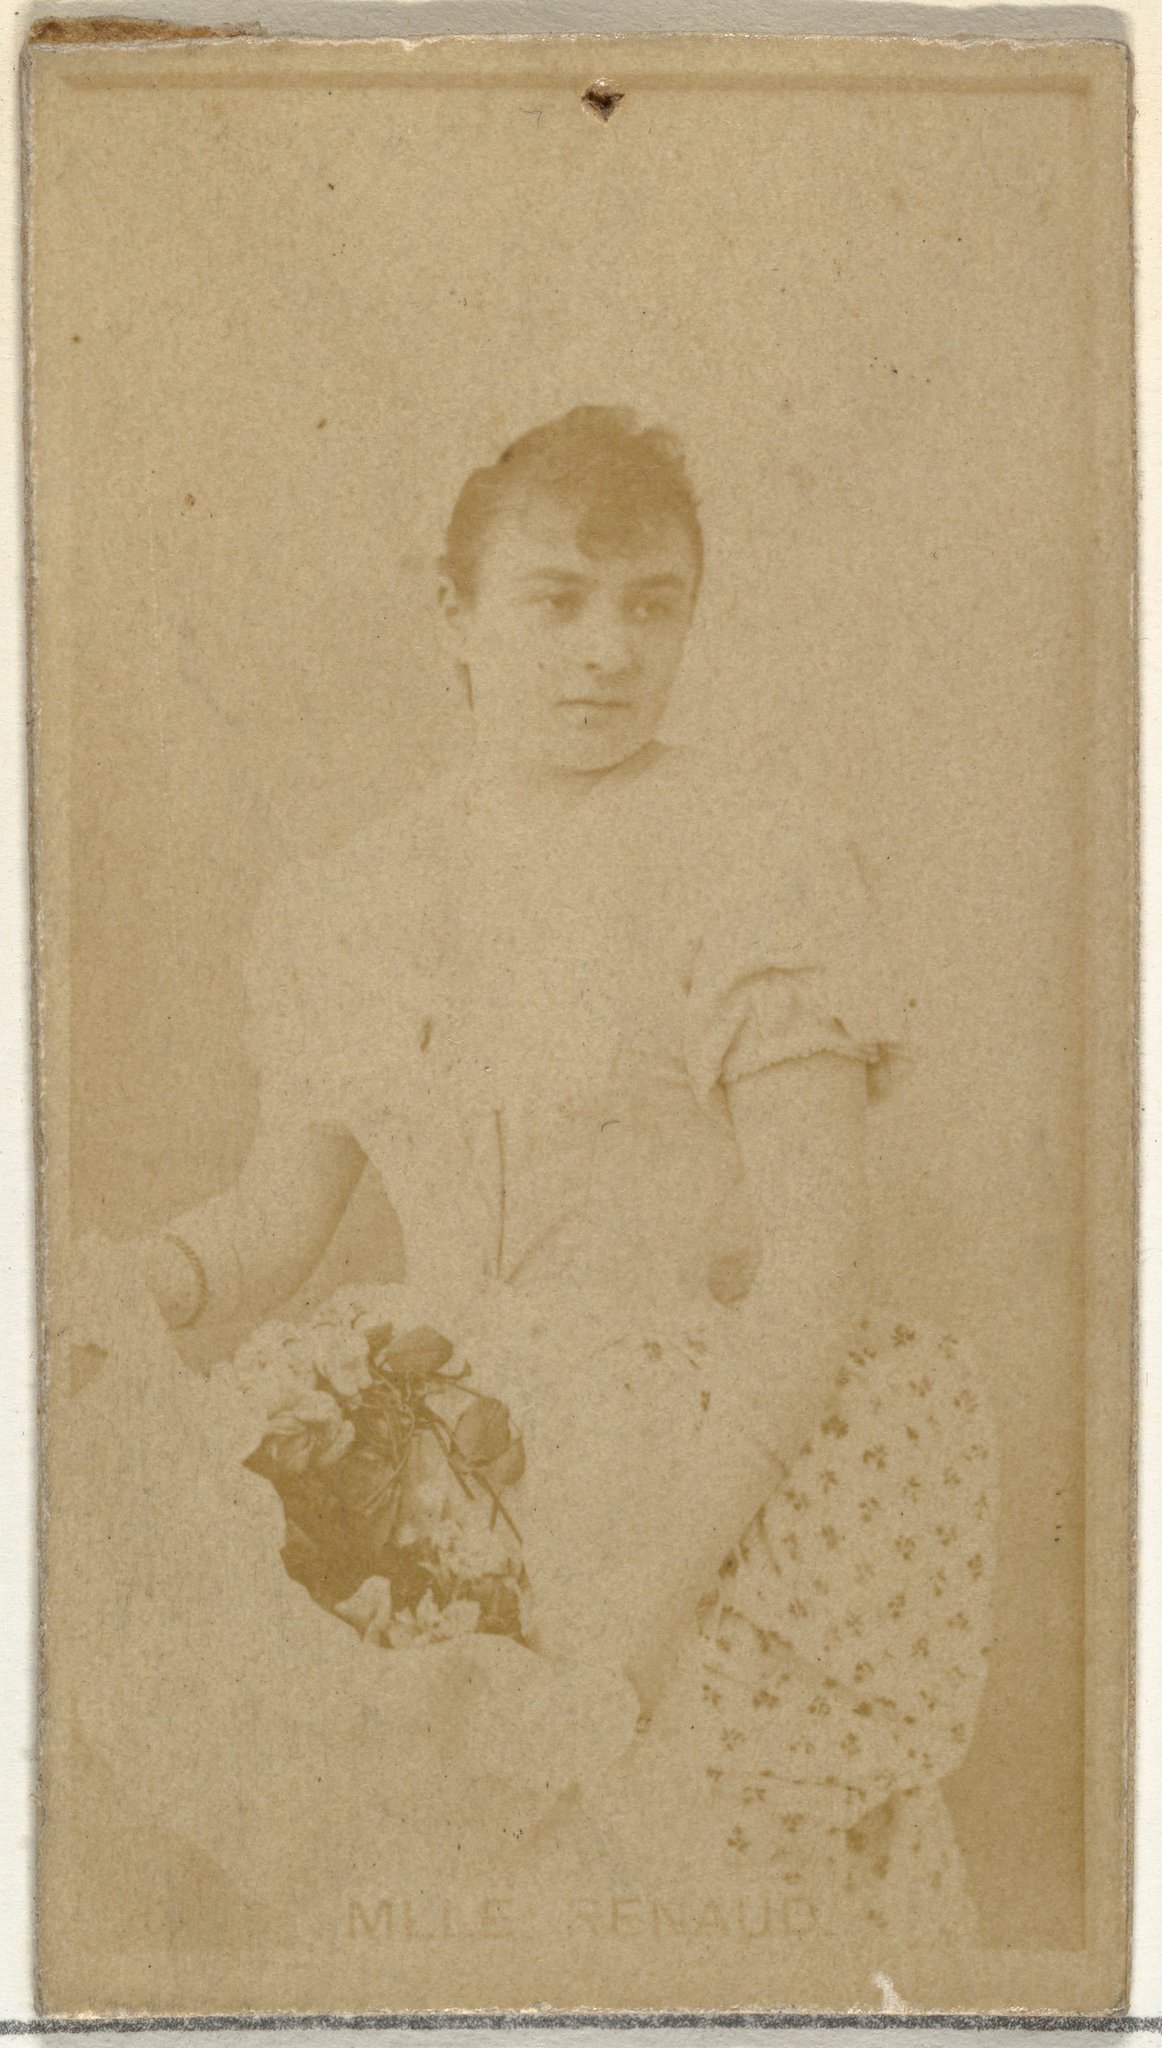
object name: photograph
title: Mlle. Renaud, from the Actors and Actresses series (N145-8) issued by Duke Sons & Co. to promote Duke Cigarettes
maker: w. duke, sons & co.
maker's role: publisher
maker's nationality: american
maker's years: 1870-1920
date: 1891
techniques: albumen silver print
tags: portraits,women,actresses